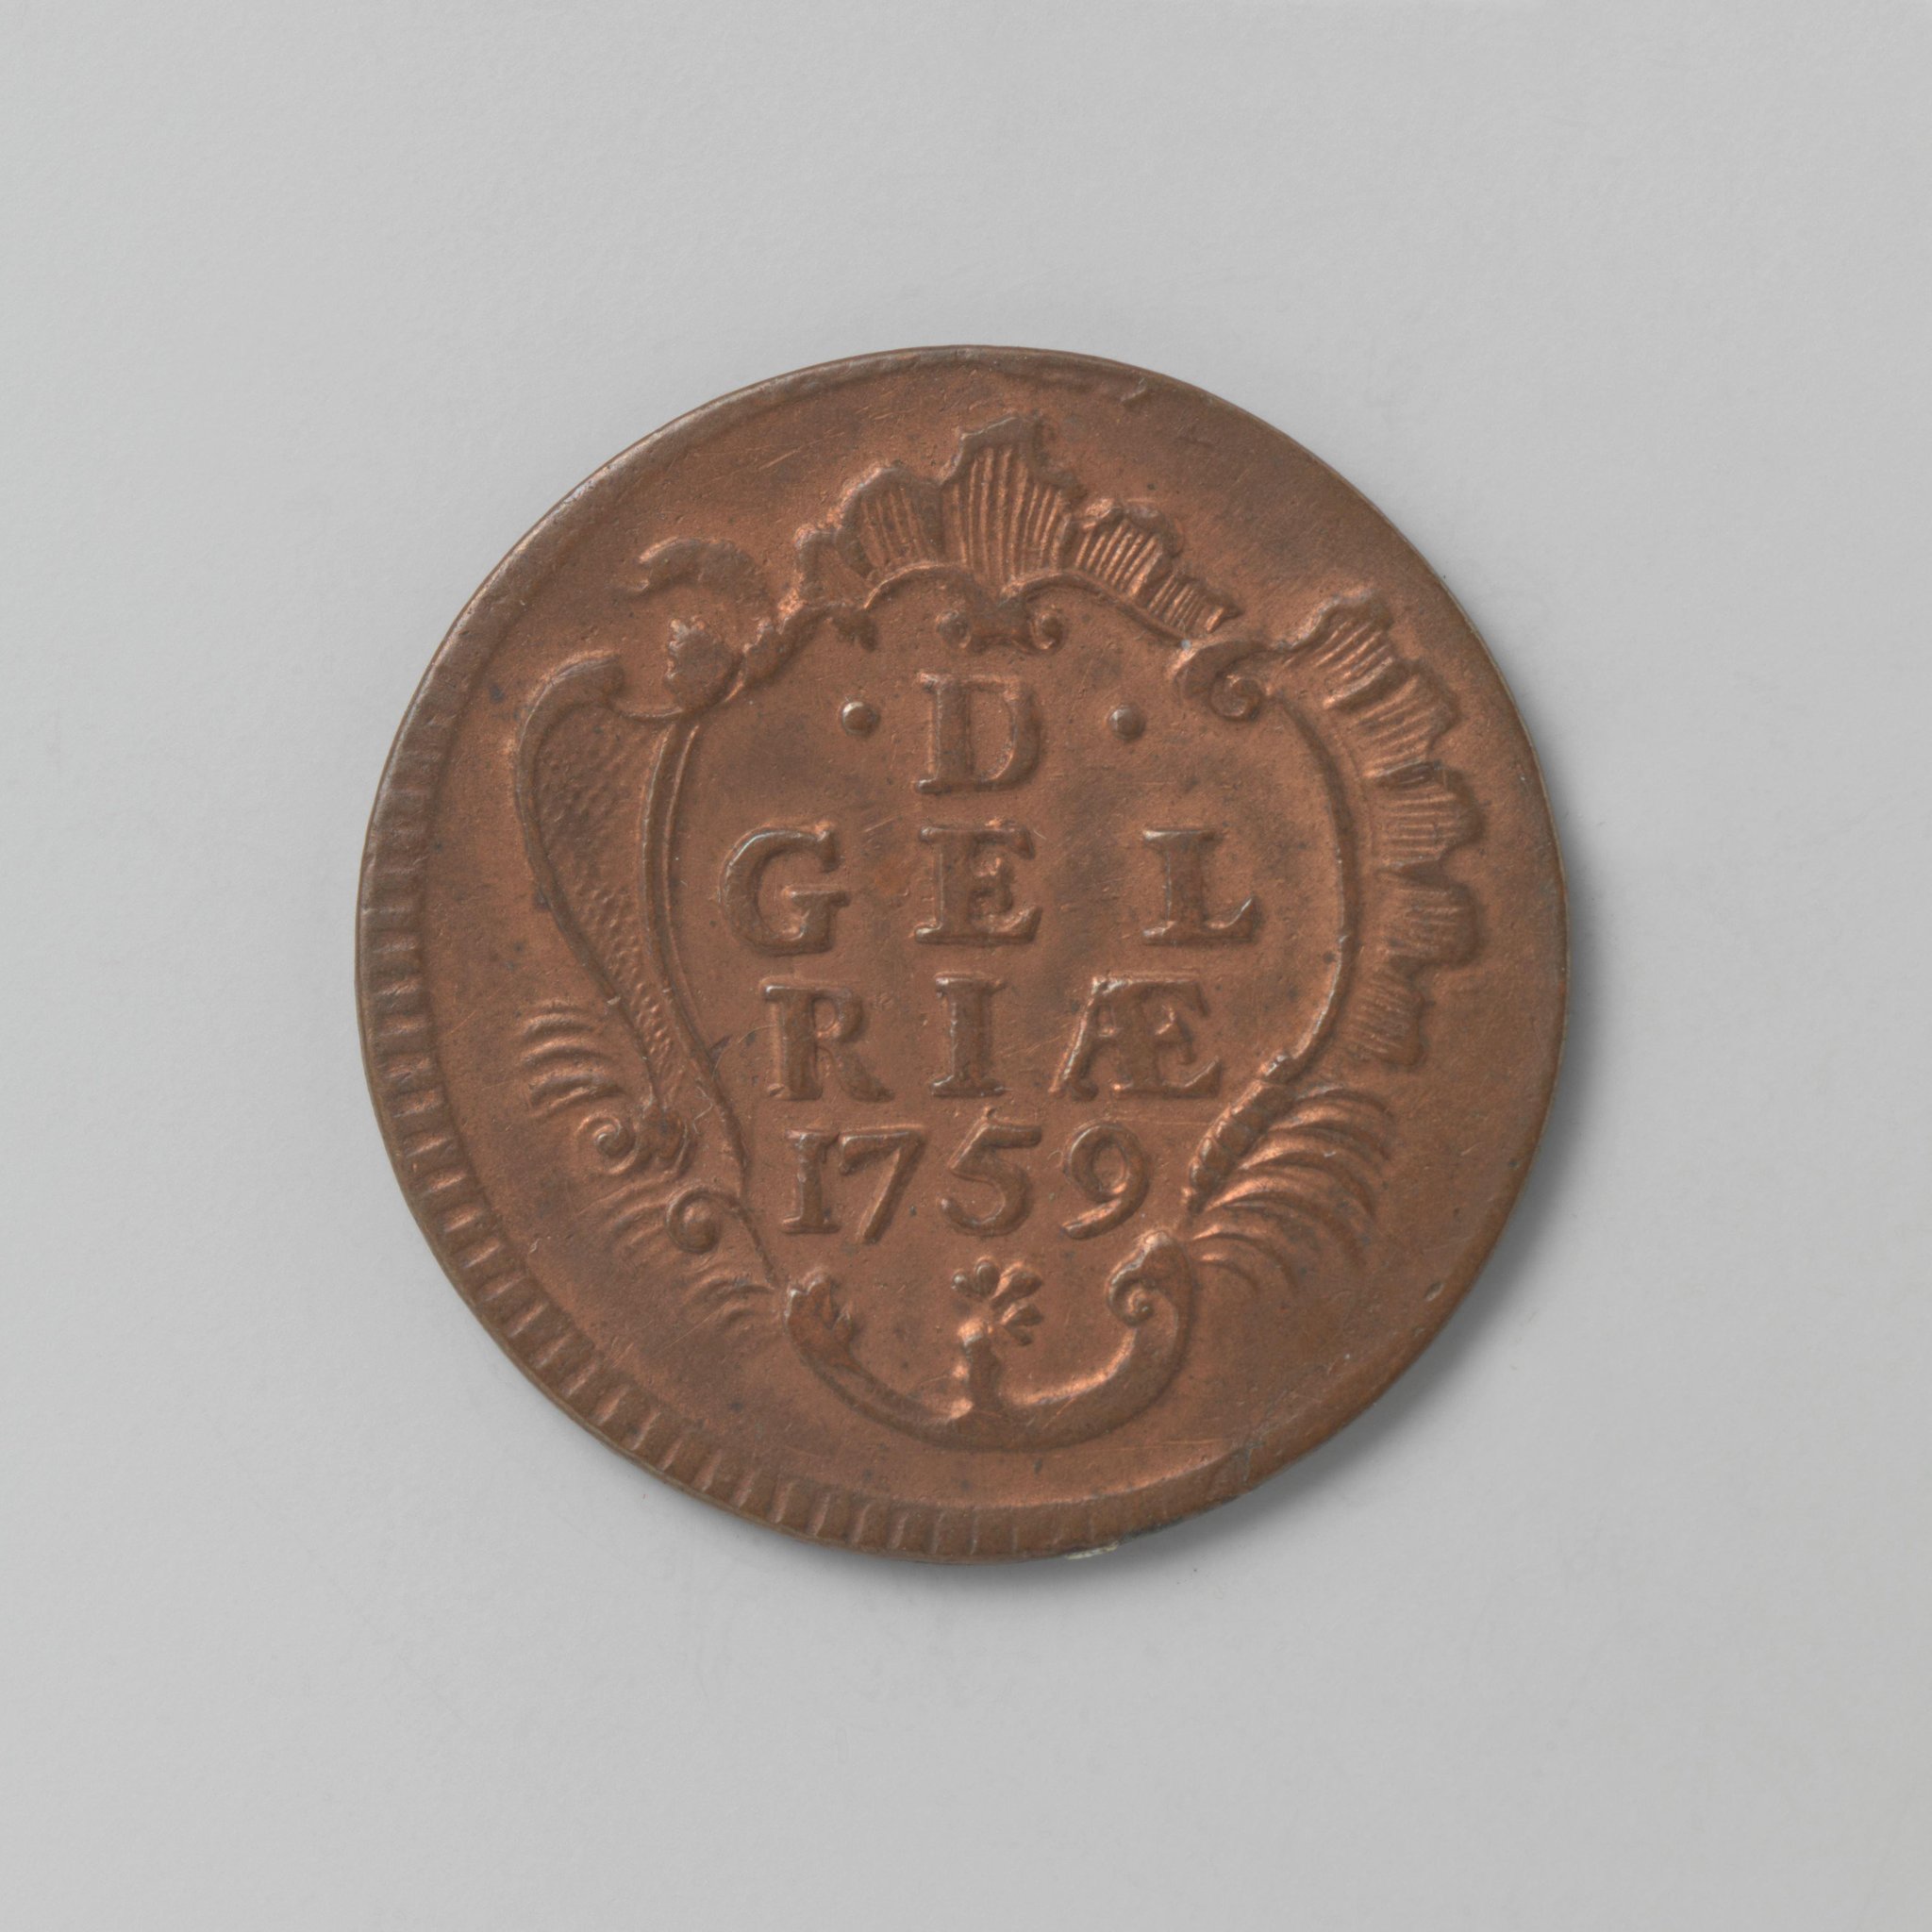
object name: coin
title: Gelderland, duit, 1759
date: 1759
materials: copper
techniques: striking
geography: harderwijk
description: Koperen munt. Voorzijde: binnen weelderige rococo-versiering in drie regels D/GEL/RIAE, daaronder jaartal en muntmeesterteken. Keerzijde: gekroond Gelders wapenschild.